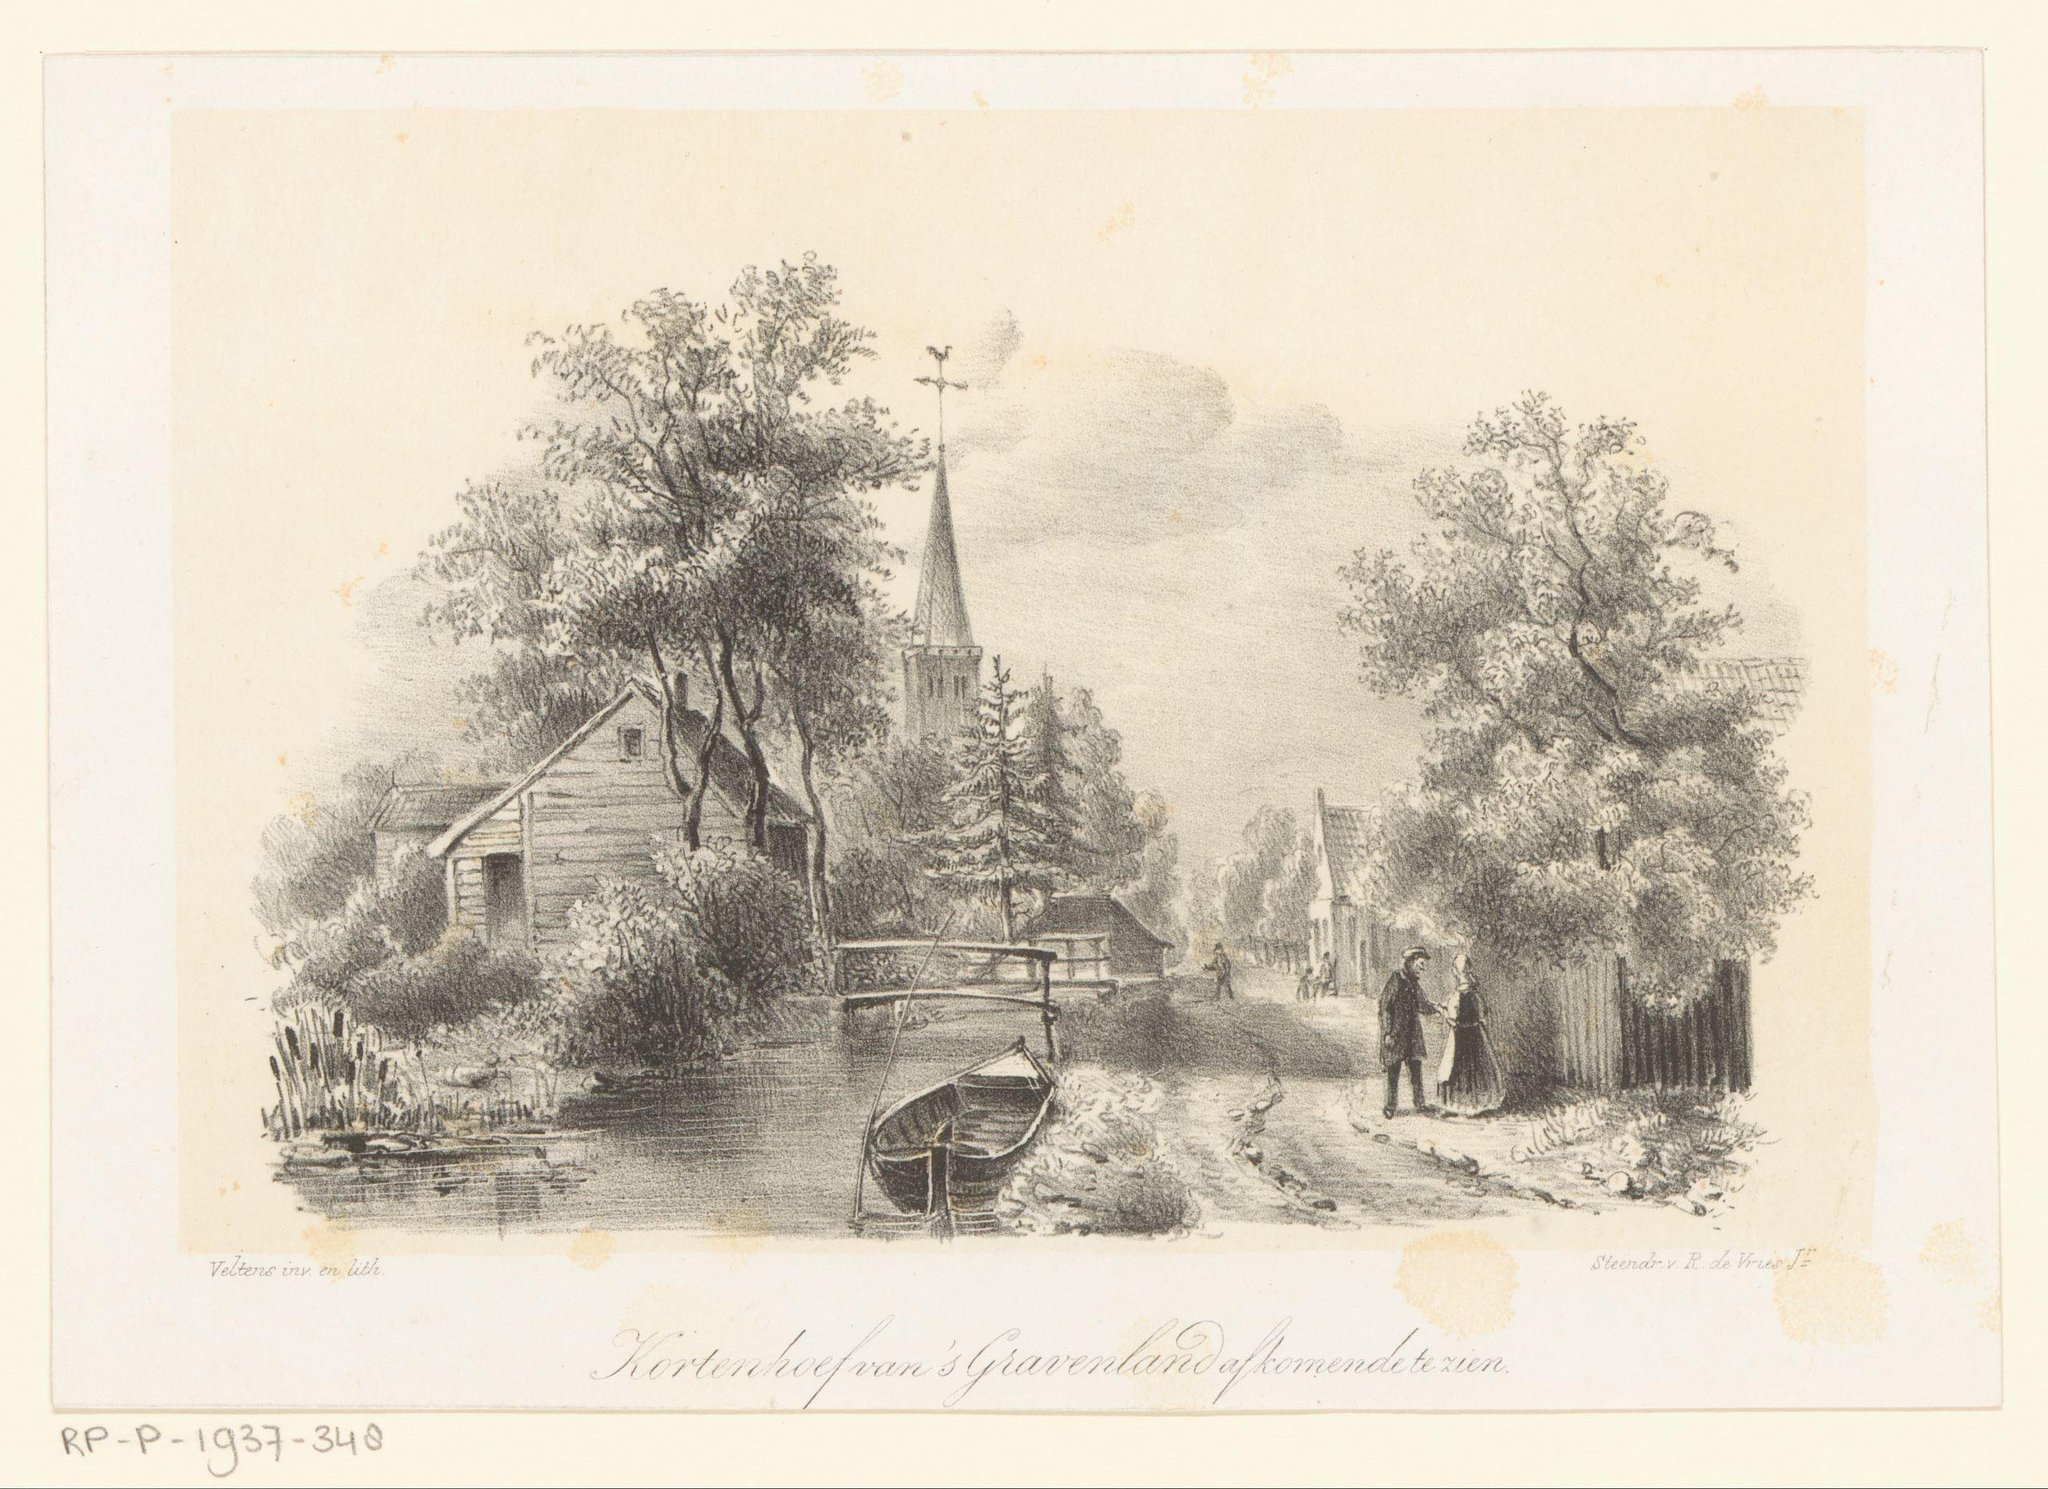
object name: print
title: Kortenhoef van 's Gravenland afkomende te zien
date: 1824-1874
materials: paper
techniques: tone lithography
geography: netherlands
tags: village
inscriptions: collector's mark: Lugt 2228, collector's mark: Lugt 2760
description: Gezicht op het dorp Kortenhoef met een boot op het water en in de achtergrond de kerktoren.